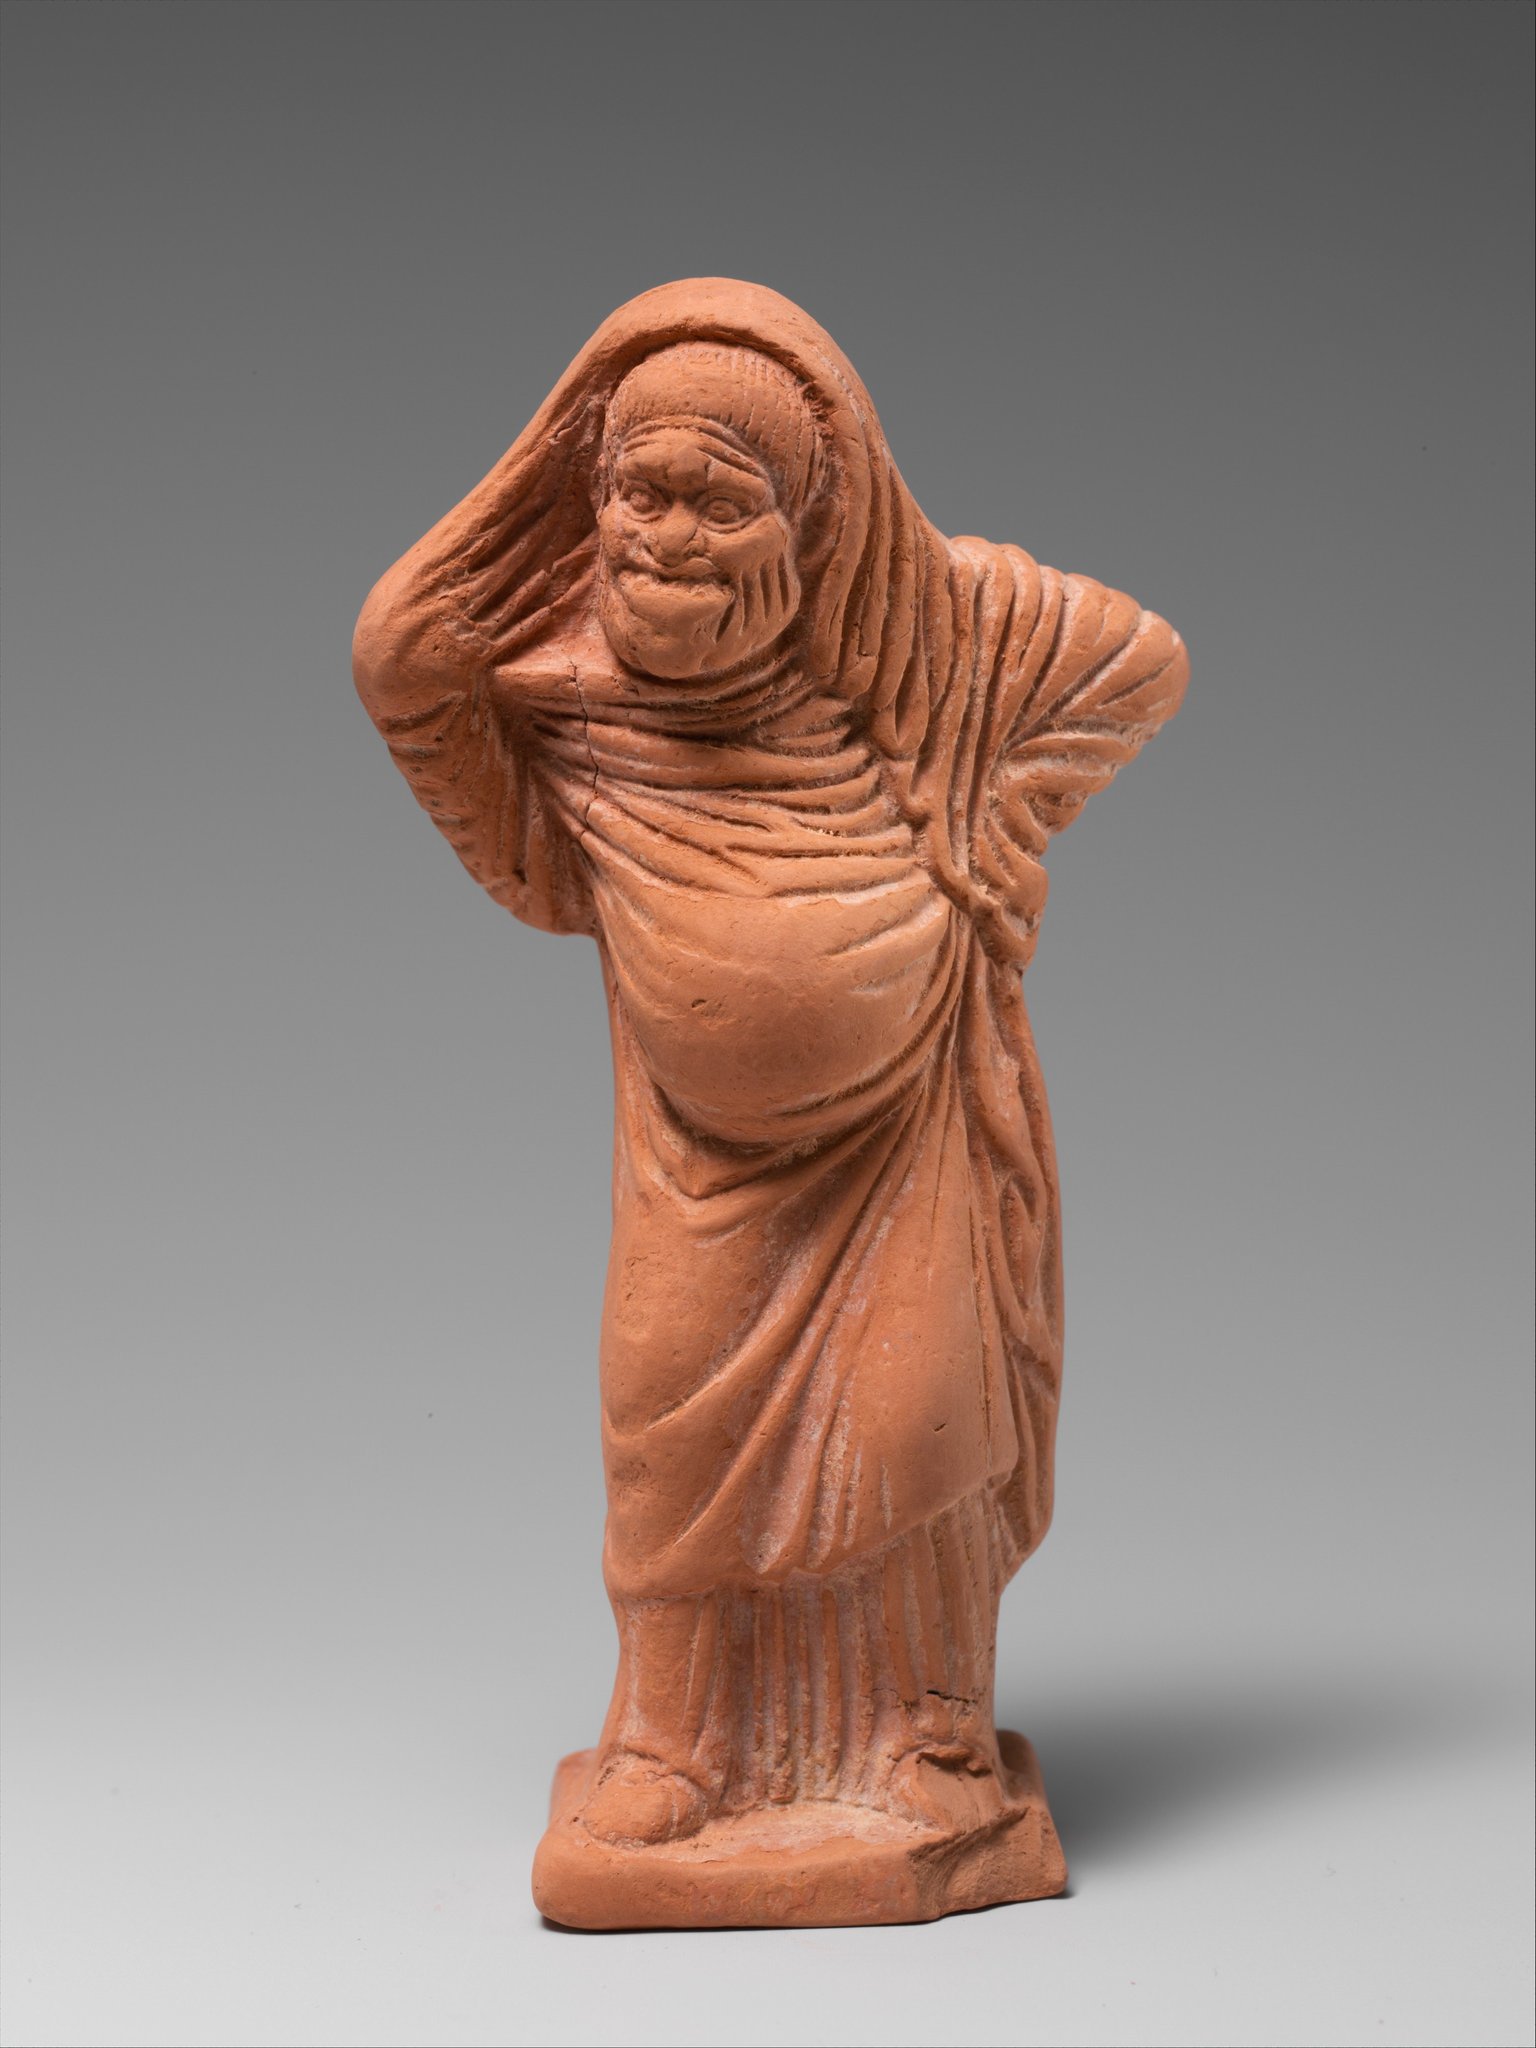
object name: statuette of an actor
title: Terracotta statuette of an actor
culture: greek, attic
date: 434-368 BCE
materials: terracotta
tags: human figures,actors